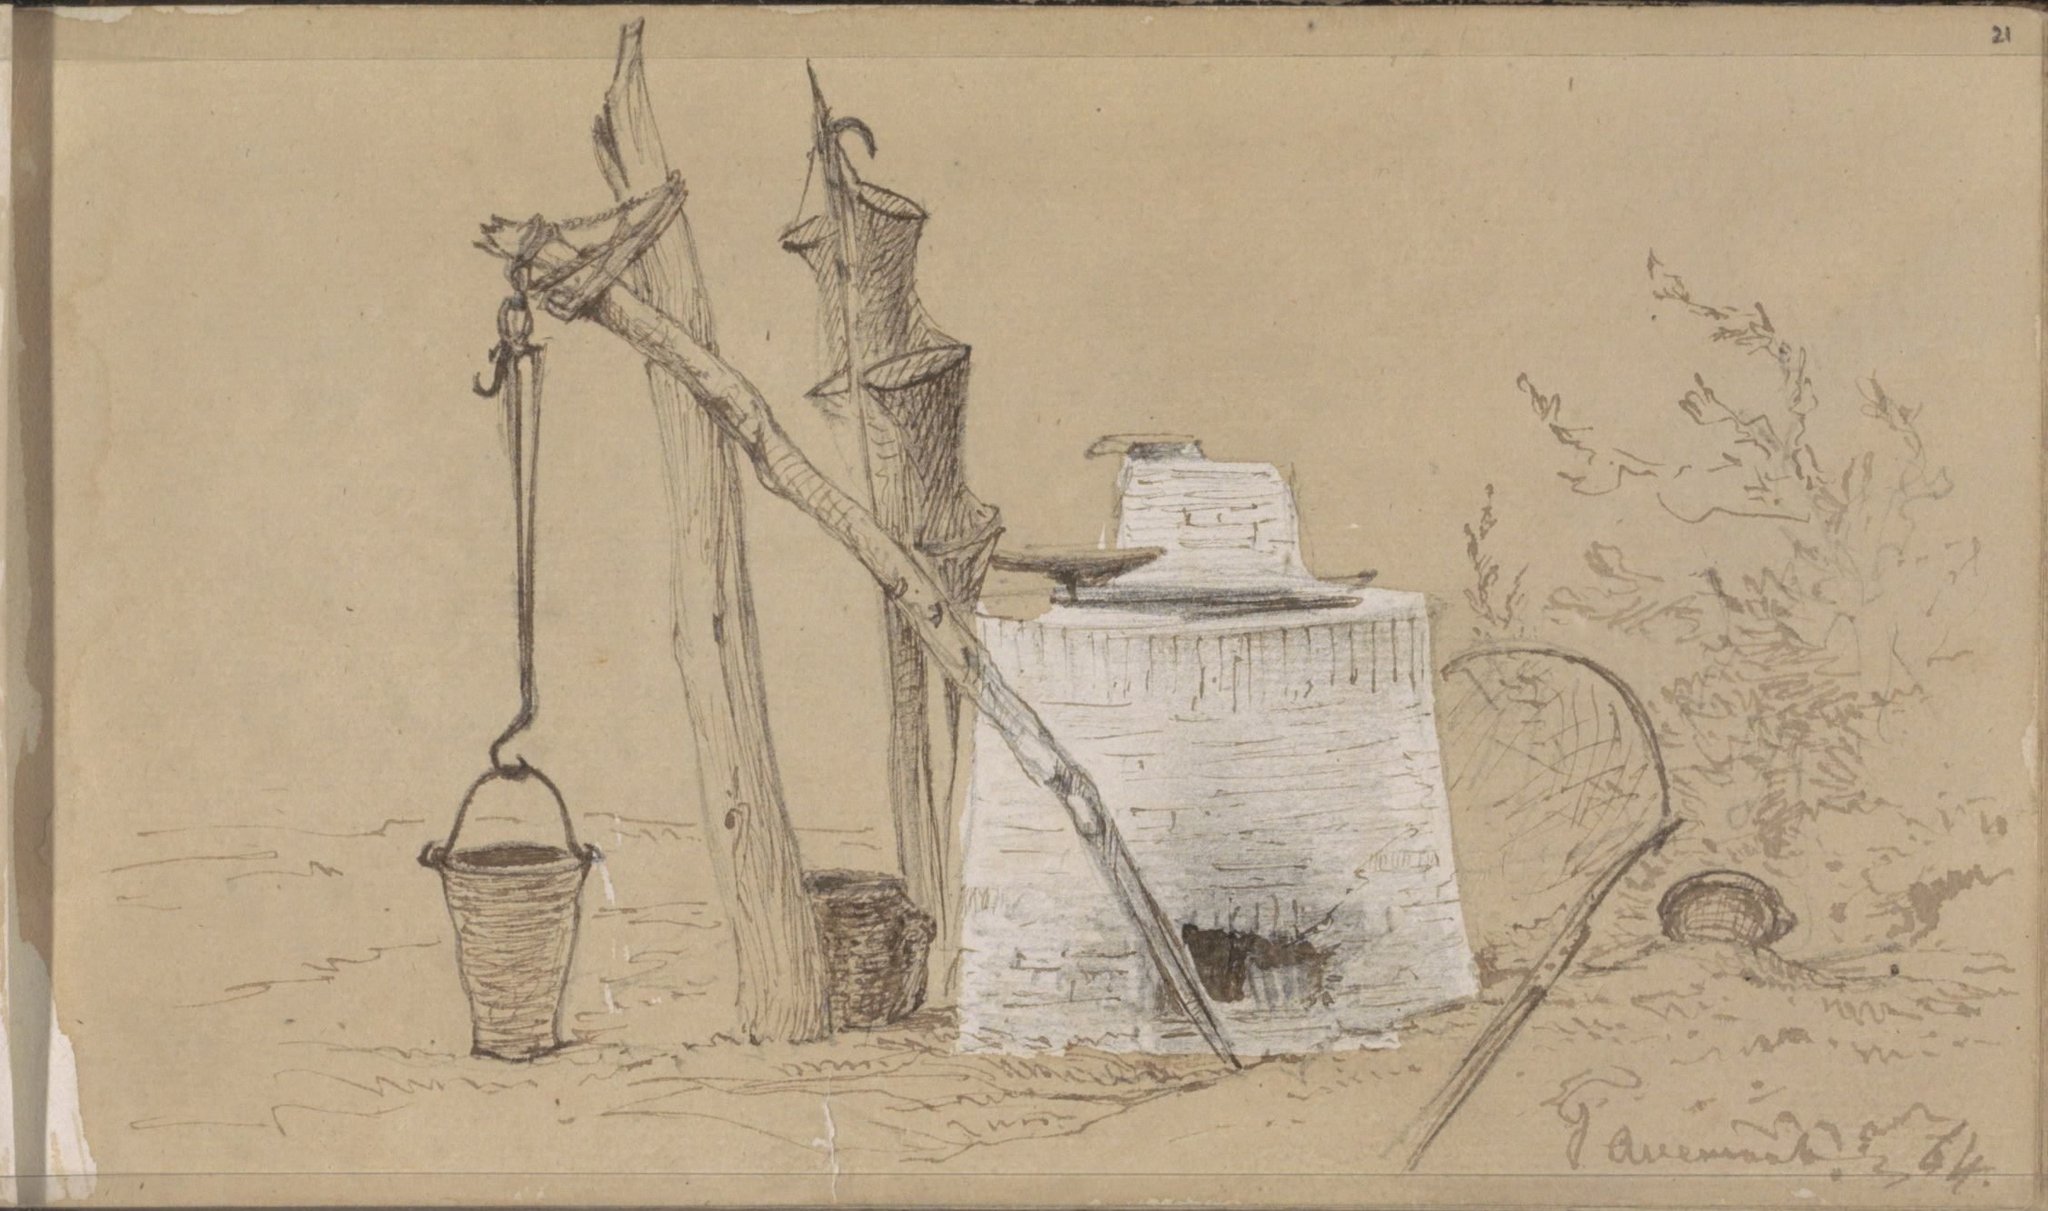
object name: sketchbook leaf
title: Rookoven op een stuk grond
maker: johannes tavenraat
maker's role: draughtsman, painter, print maker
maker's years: 1809-1881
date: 1864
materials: ink, paper, pencil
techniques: brush, pen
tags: wooden container: barrel, cask, bucket, oven ~ kitchen - cc - in the open air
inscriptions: signature: ‘Tavenraat’, date: ‘64’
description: Naast de oven staan palen, emmers en een visnet. Blad 21 recto uit een schetsboek met 98 bladen.